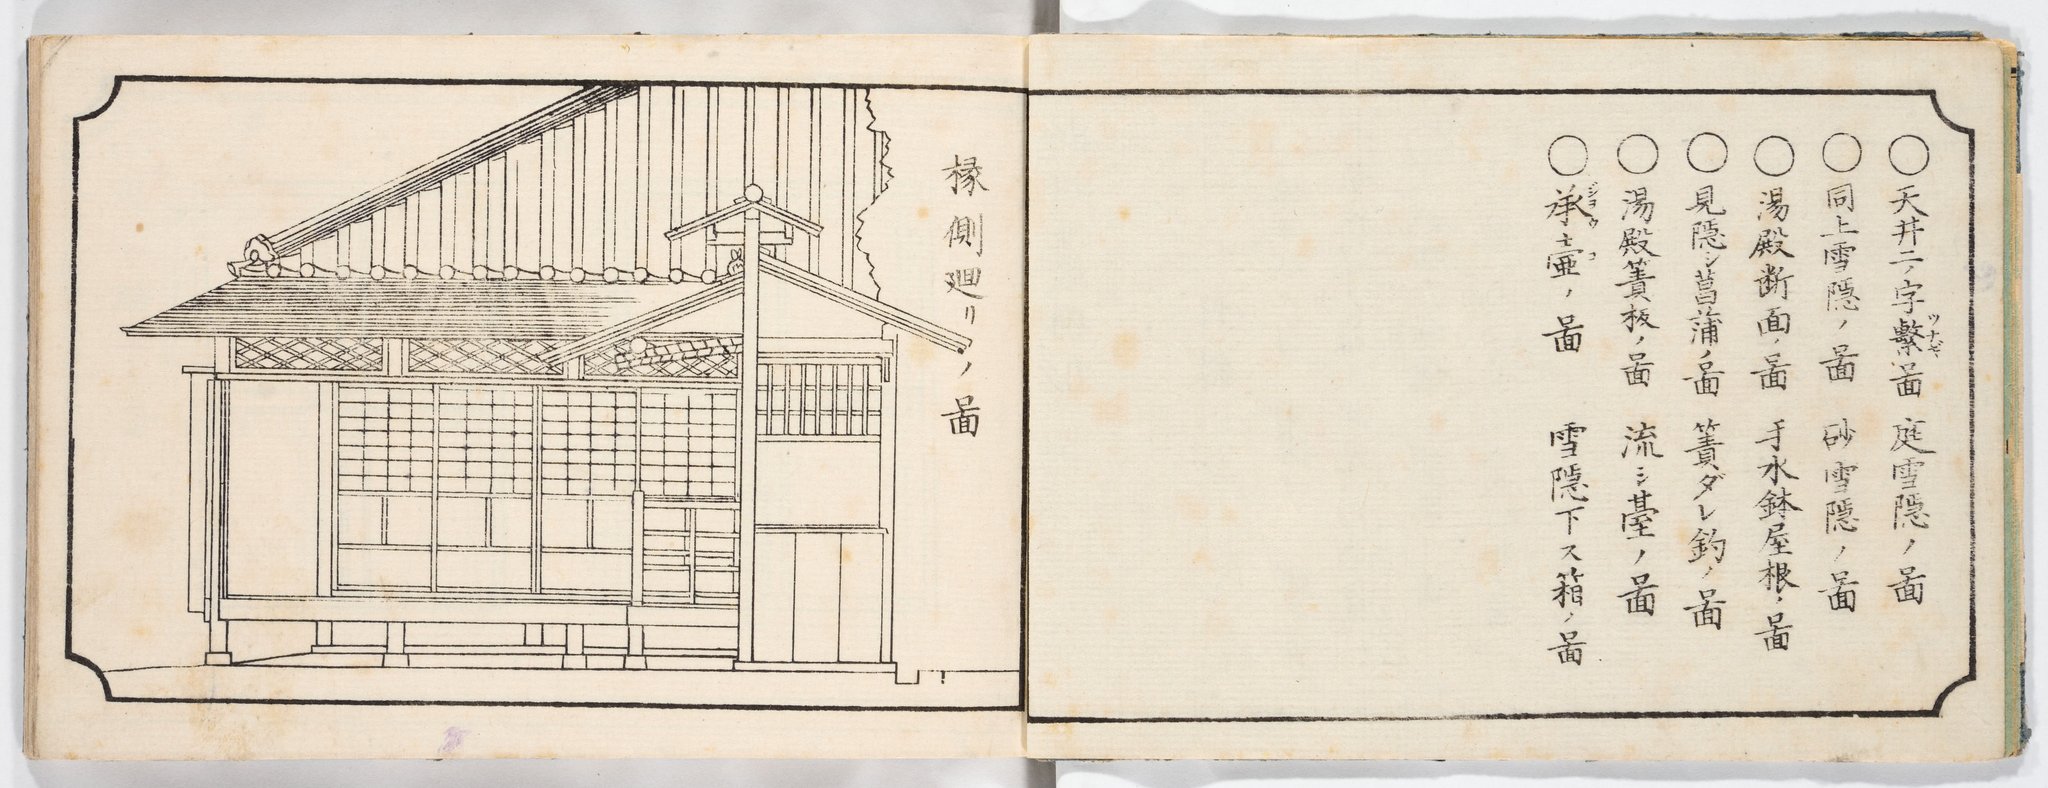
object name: illustrated book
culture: japanese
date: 1893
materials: ink, paper